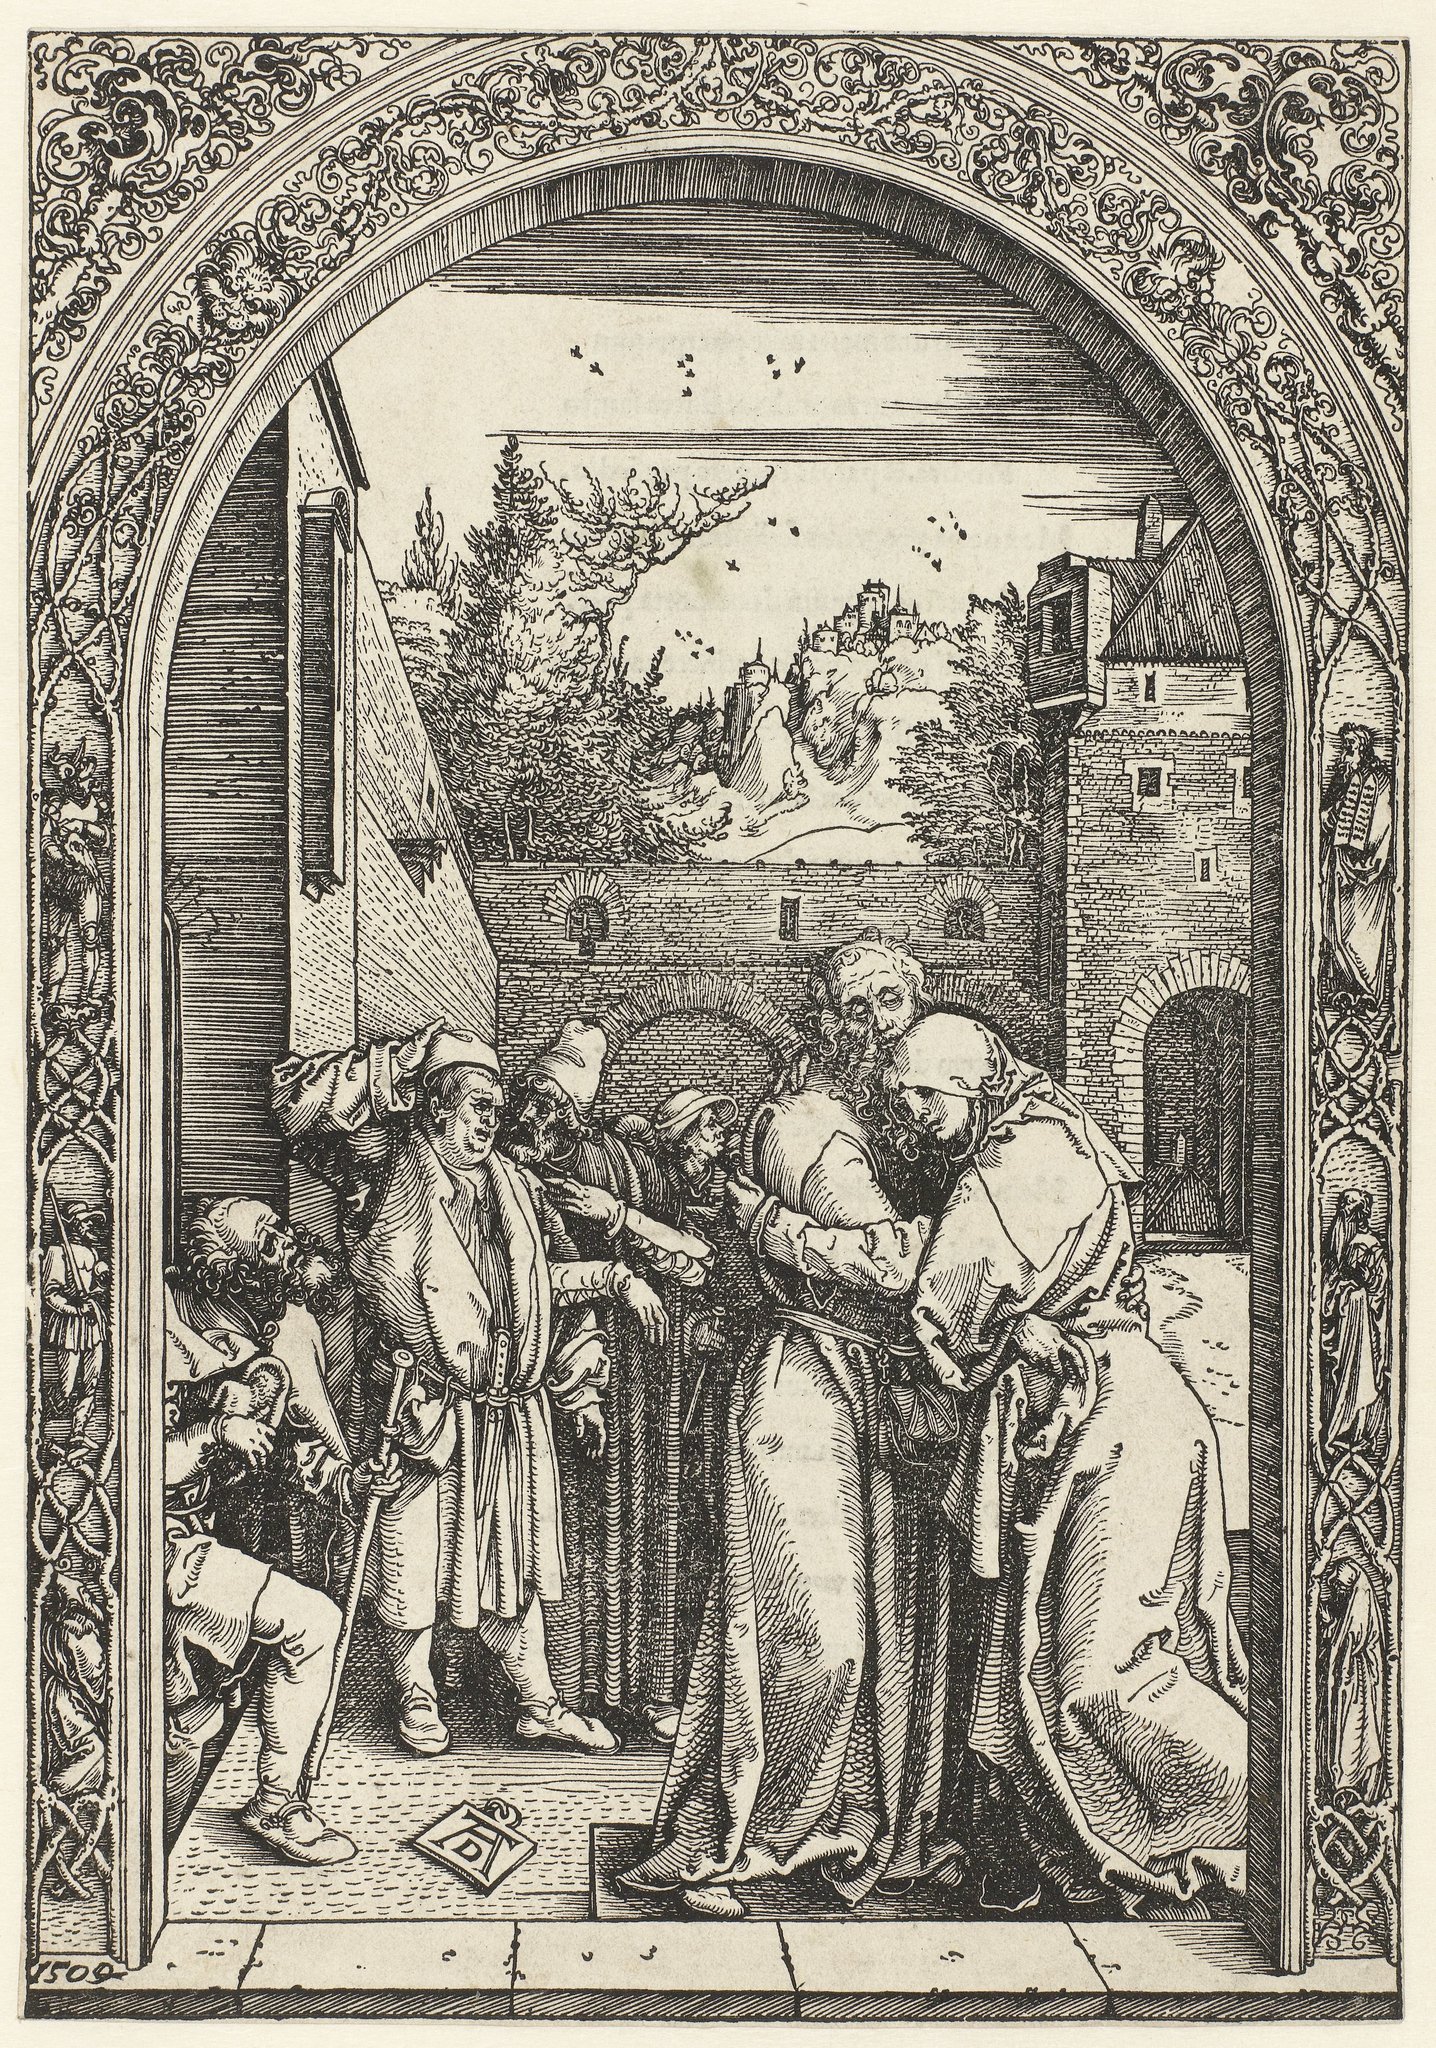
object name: print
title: De ontmoeting bij de Gouden Poort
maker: albrecht dürer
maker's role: draughtsman, painter, print maker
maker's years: 1471-1528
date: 1504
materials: paper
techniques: letterpress printing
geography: nuremberg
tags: meeting of anna and joachim at the golden gate; they usually embrace or kiss each other (immaculate conception of mary)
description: Joachim en Anna omhelzen elkaar bij een poort, te midden van enkele omstanders. Op versozijde gedrukte Latijnse tekst. Deze prent is onderdeel van een serie van 20 prenten, bestaand uit een titelprent en 19 prenten met scènes uit het leven van Maria.